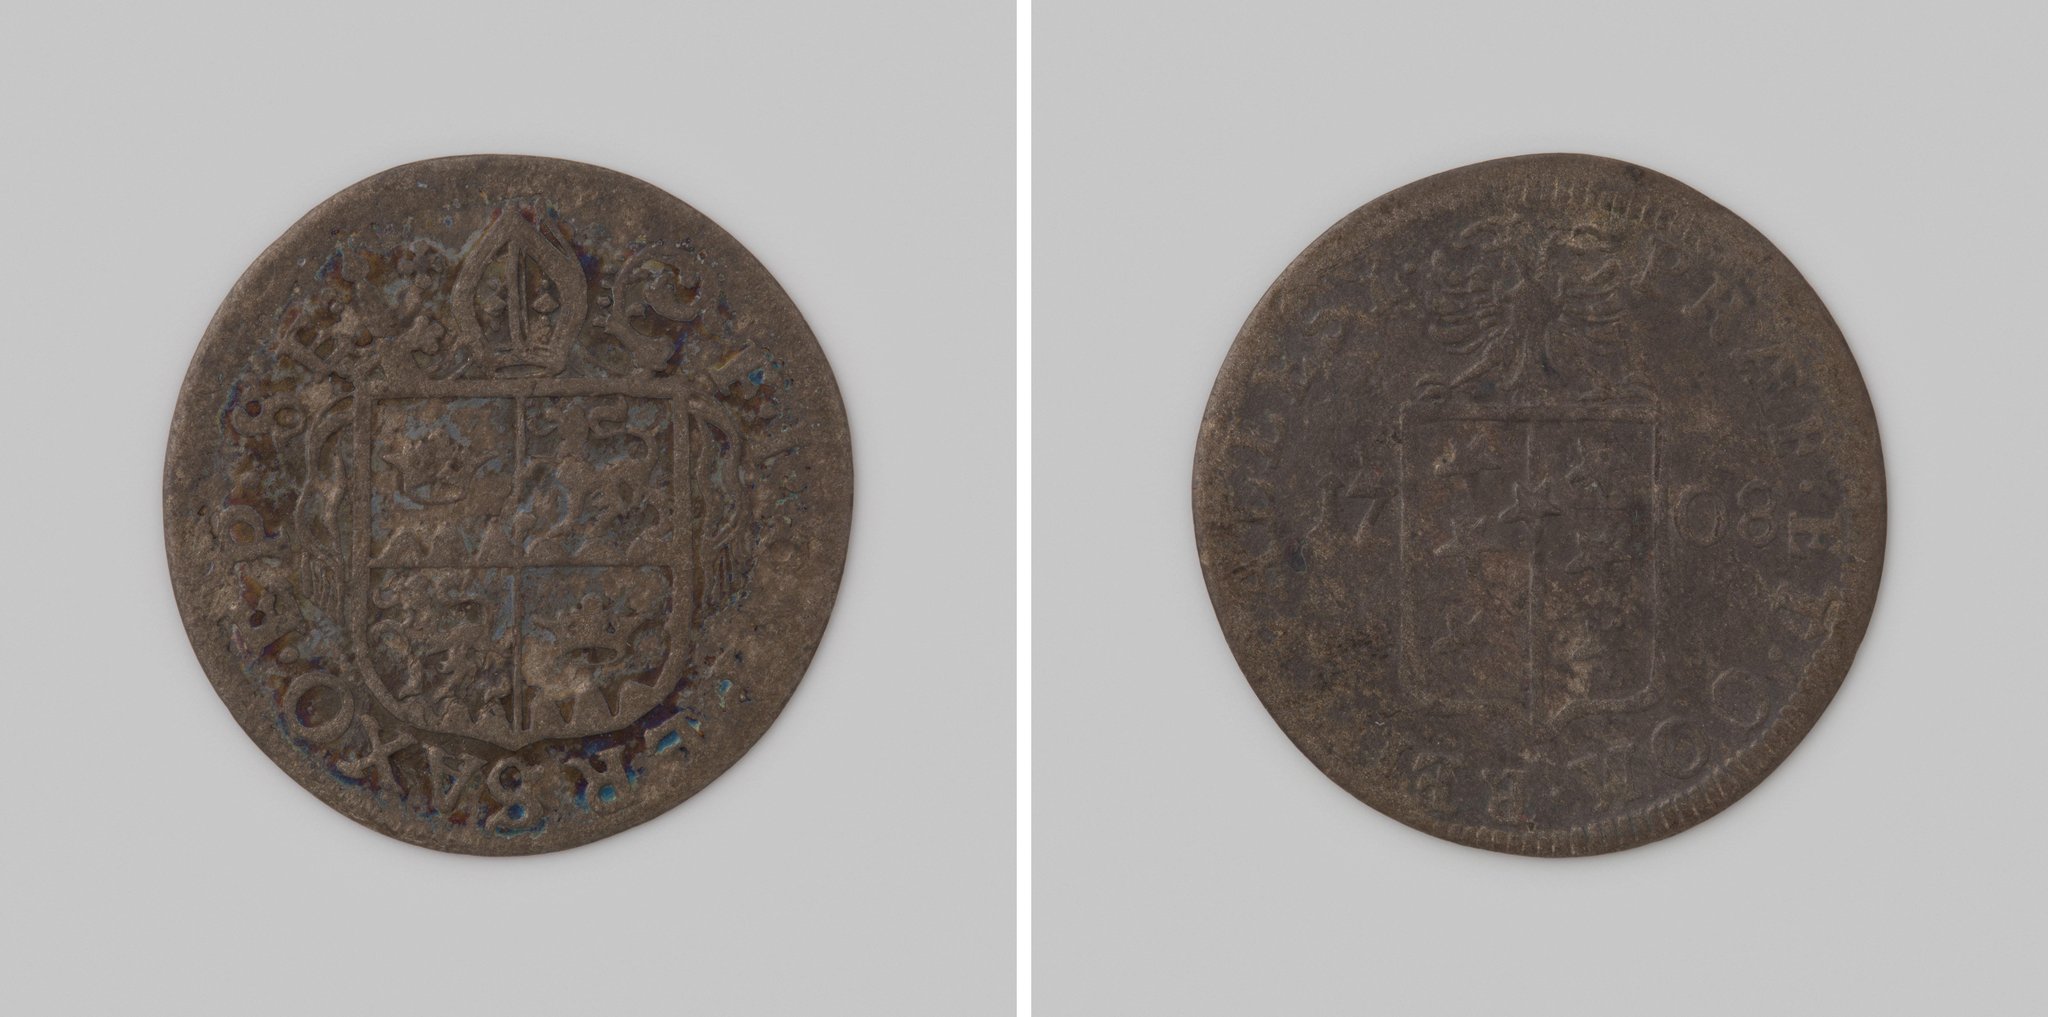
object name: coin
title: Batz uit het bisdom Sitten (Sion) van Franz I Joseph, 1708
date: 1708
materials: silver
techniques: striking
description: Zilveren munt. Voorzijde: samengesteld wapenschild, waaromheen attributen van de bisschop. Keerzijde: tussen jaartal wapenschild, waarboven adelaar. Gladde rand.